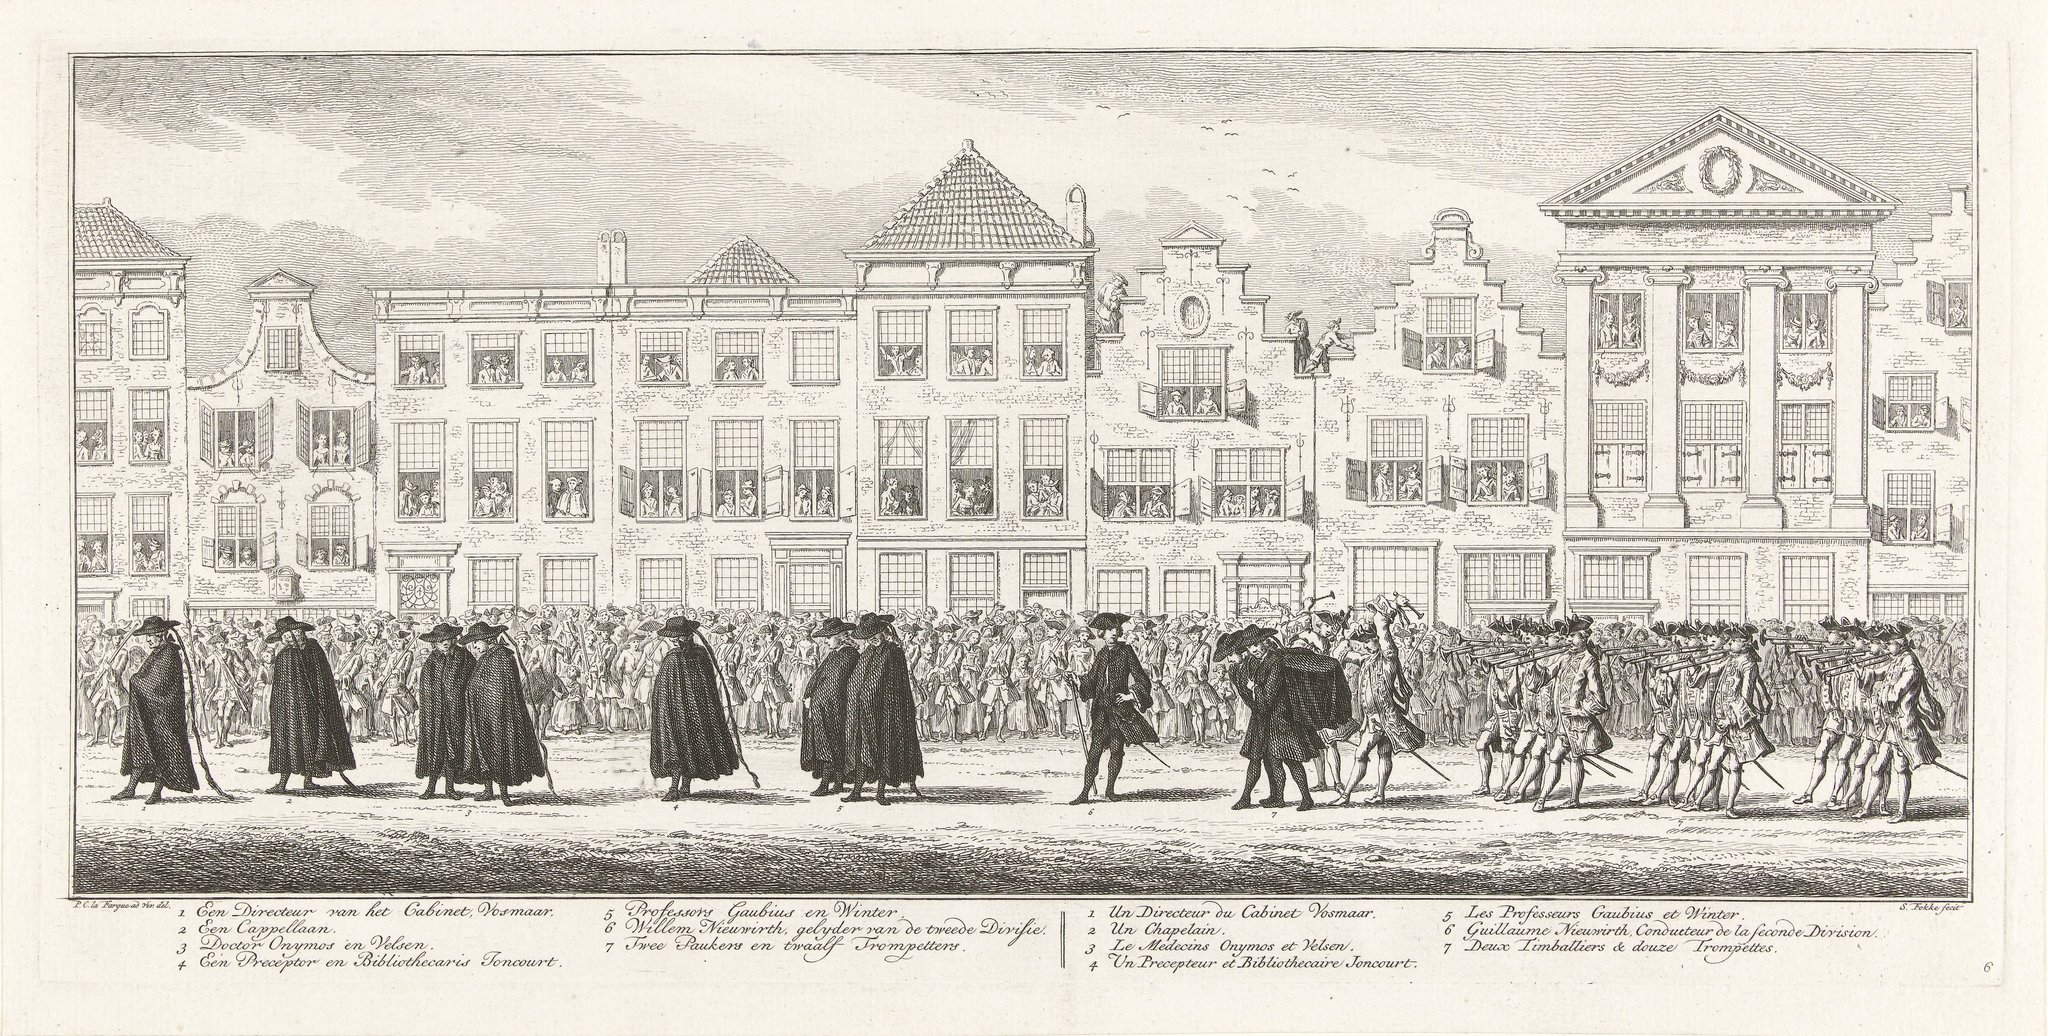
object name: print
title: Lijkstatie van prinses Anna, 1759, plaat 6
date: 1759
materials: paper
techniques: engraving, etching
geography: northern netherlands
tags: the hague, anna van hannover, cortege, funeral procession, delft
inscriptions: collector's mark: Lugt 2228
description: Leden van de stadhouderlijke hofhouding. Onderdeel van een serie van 16 platen plus een gedrukte beschrijving van de lijkstatie van de op 23 februari 1759 te Delft begraven prinses Anna van Hannover. Genummerd rechtsonder: 6.